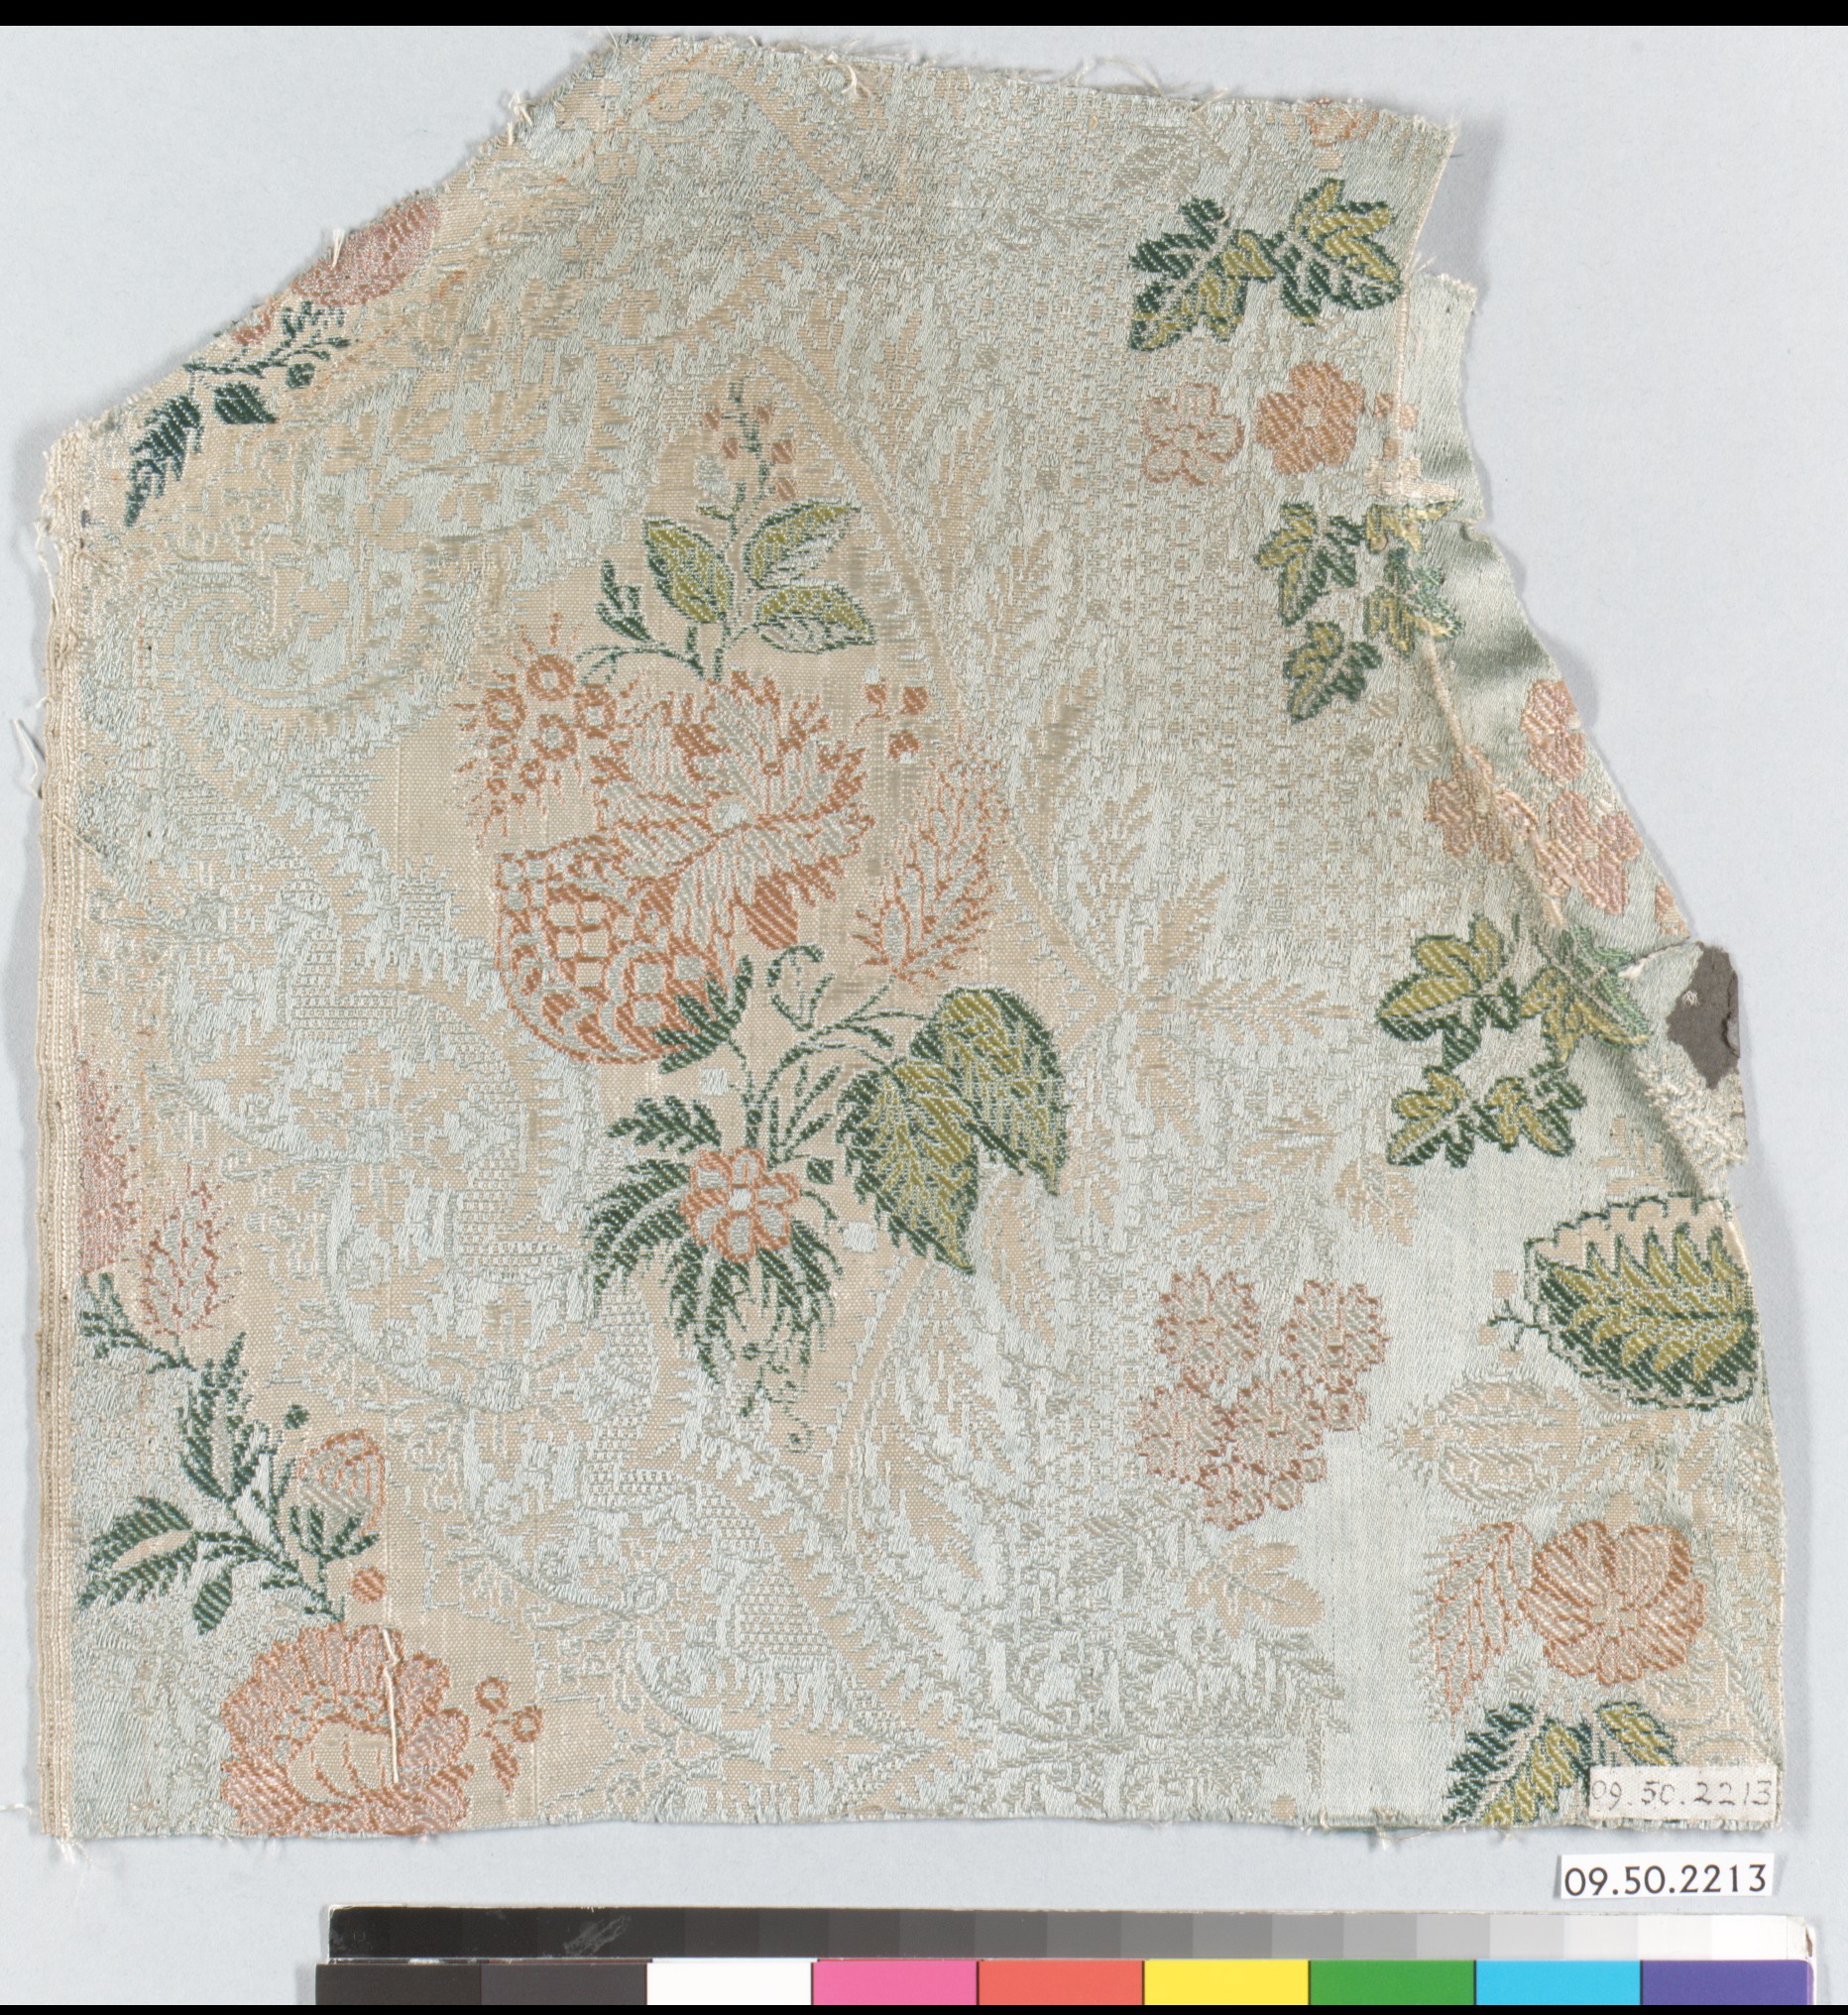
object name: piece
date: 1725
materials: silk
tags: flowers,leaves